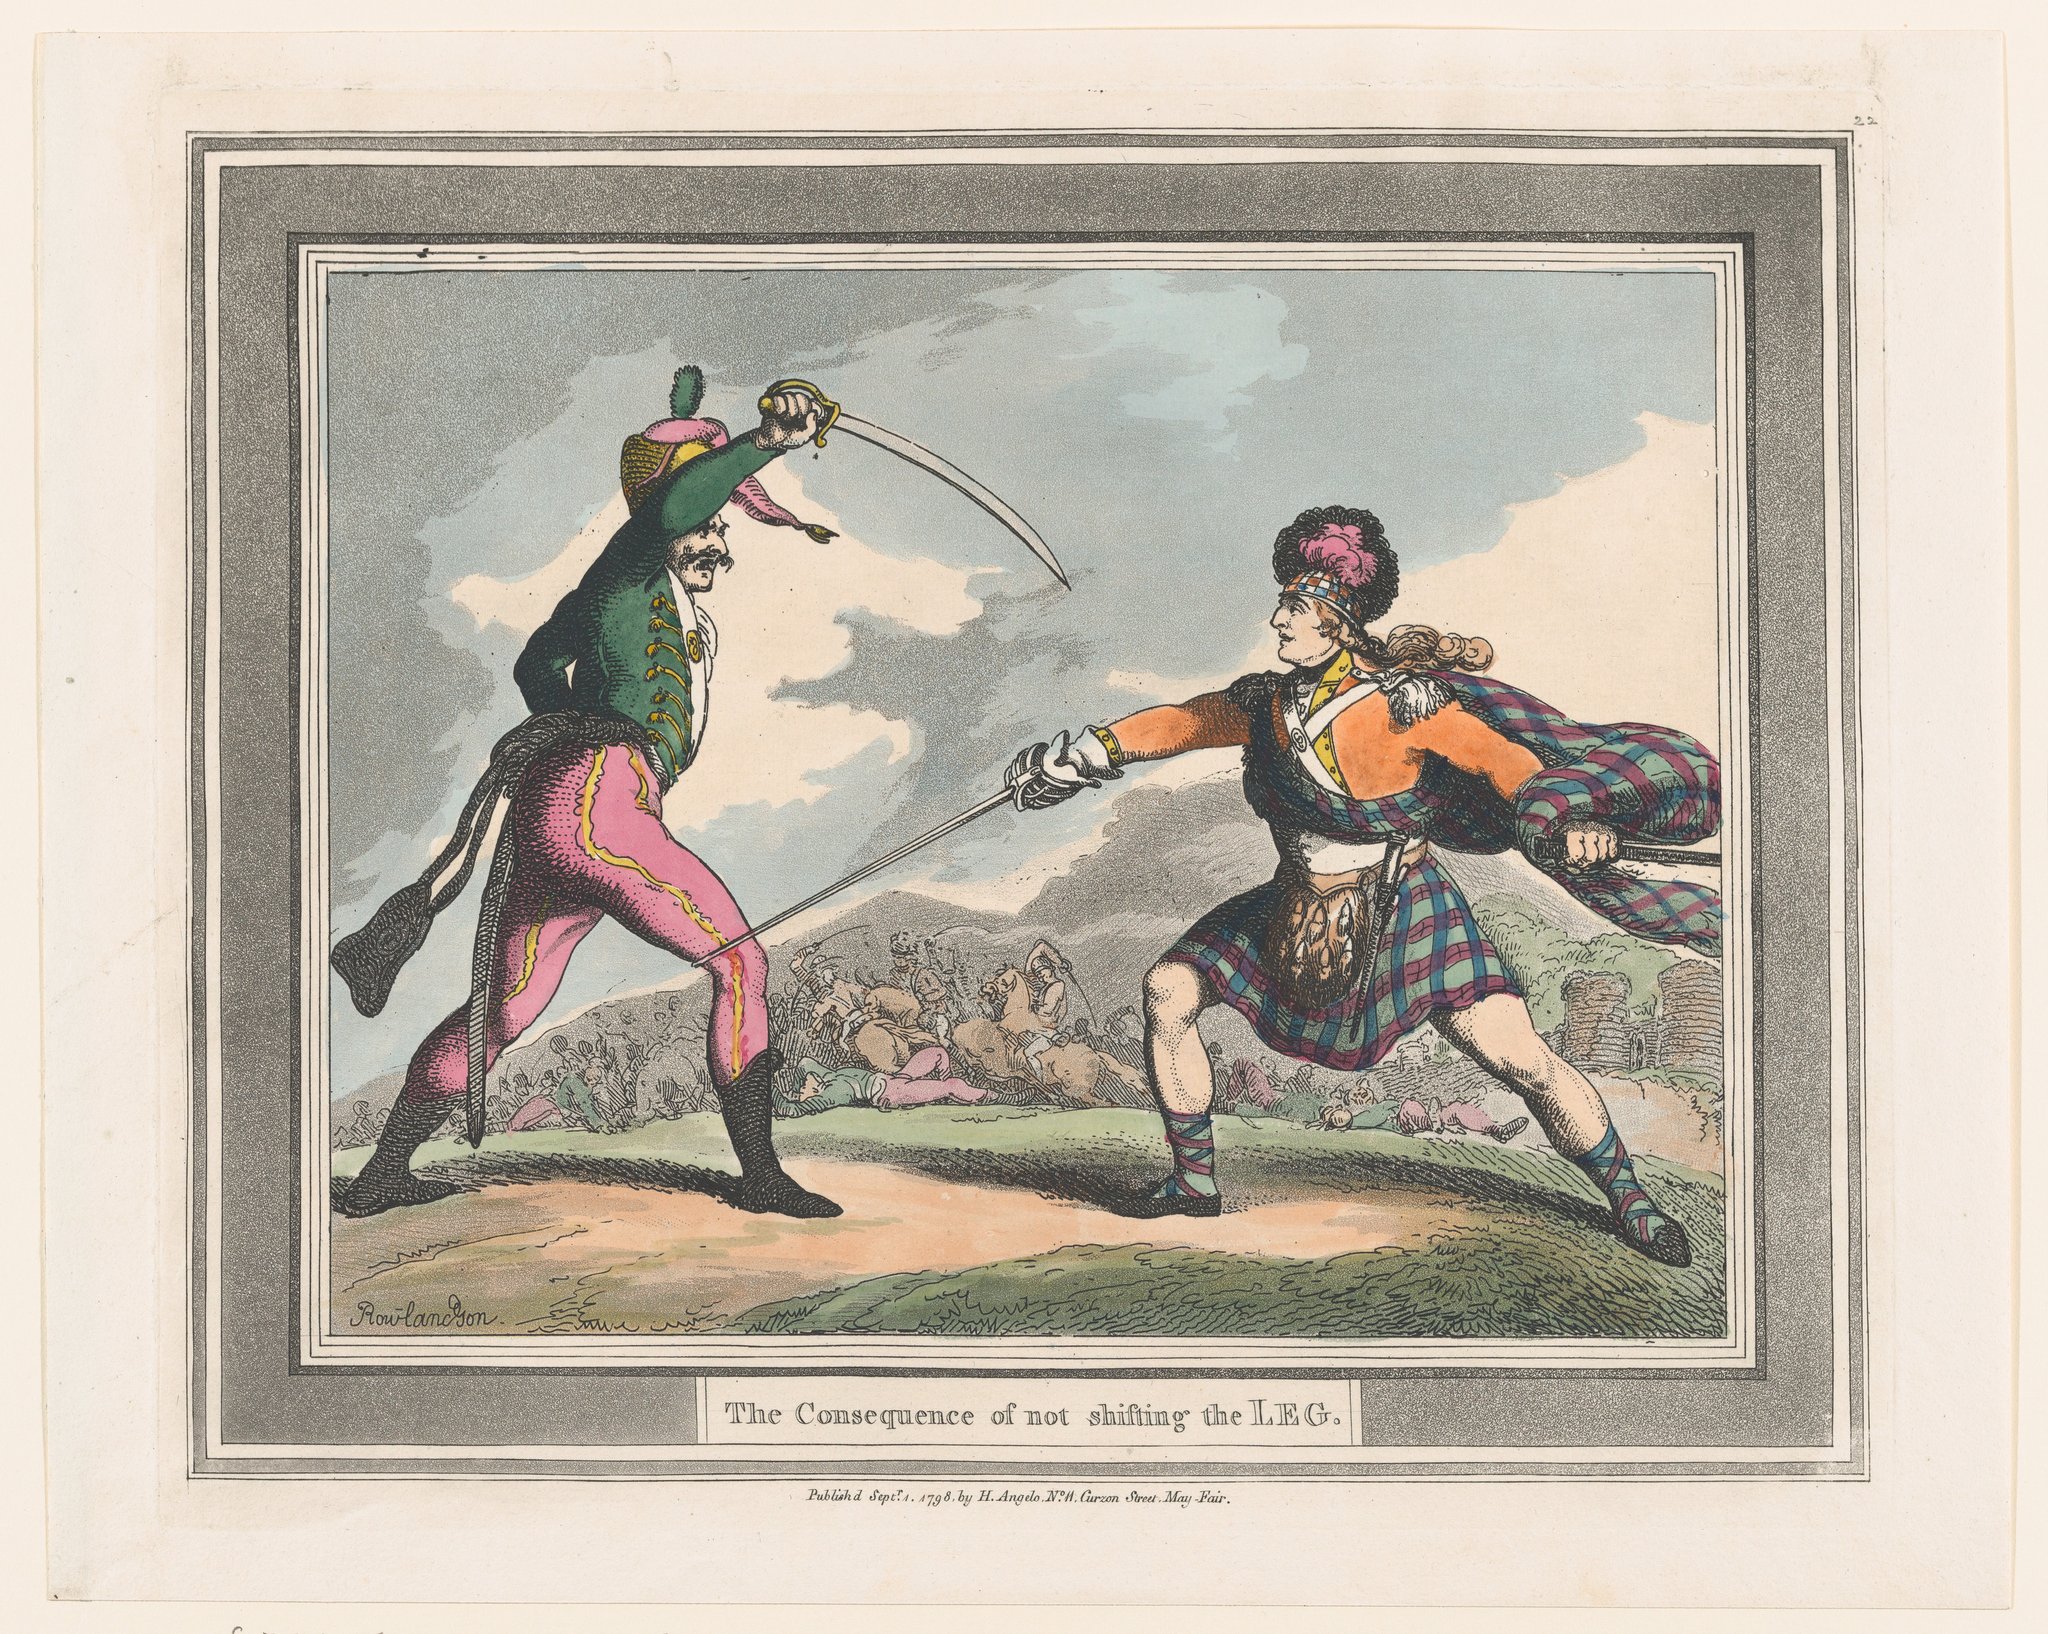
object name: print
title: The Consequence of not shifting the Leg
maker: thomas rowlandson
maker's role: artist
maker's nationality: british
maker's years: 1757-1827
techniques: aquatint, etching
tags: battles,swords,men